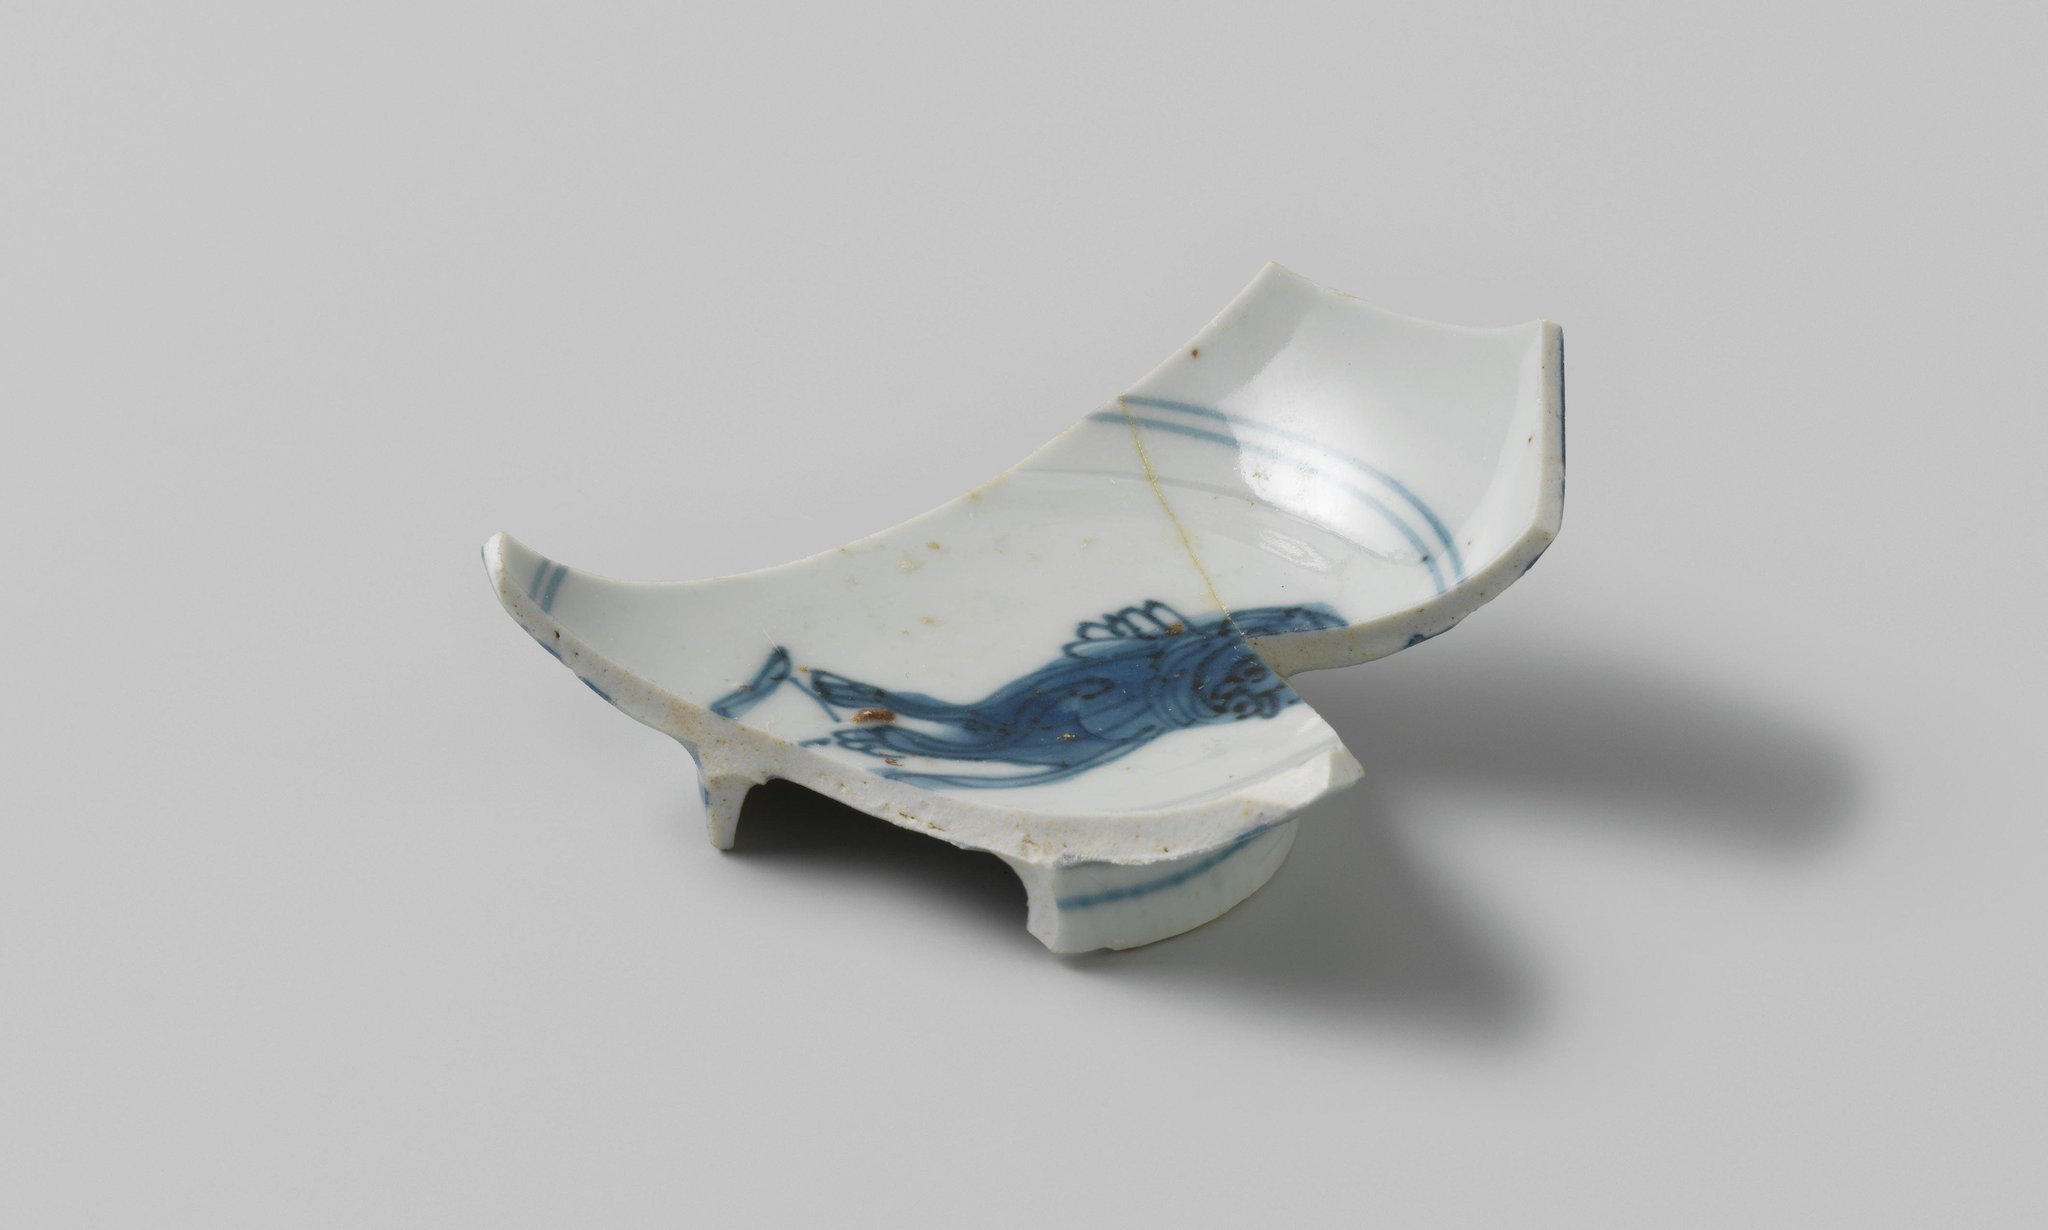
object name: sherd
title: Fragment kom uit V.O.C.-schip de 'Witte Leeuw'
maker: Anonymous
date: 1613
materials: porcelain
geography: jingdezhen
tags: verenigde oostindische compagnie, sint-helena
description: Fragment kom uit V.O.C.-schip de 'Witte Leeuw'. Bodemfragment.